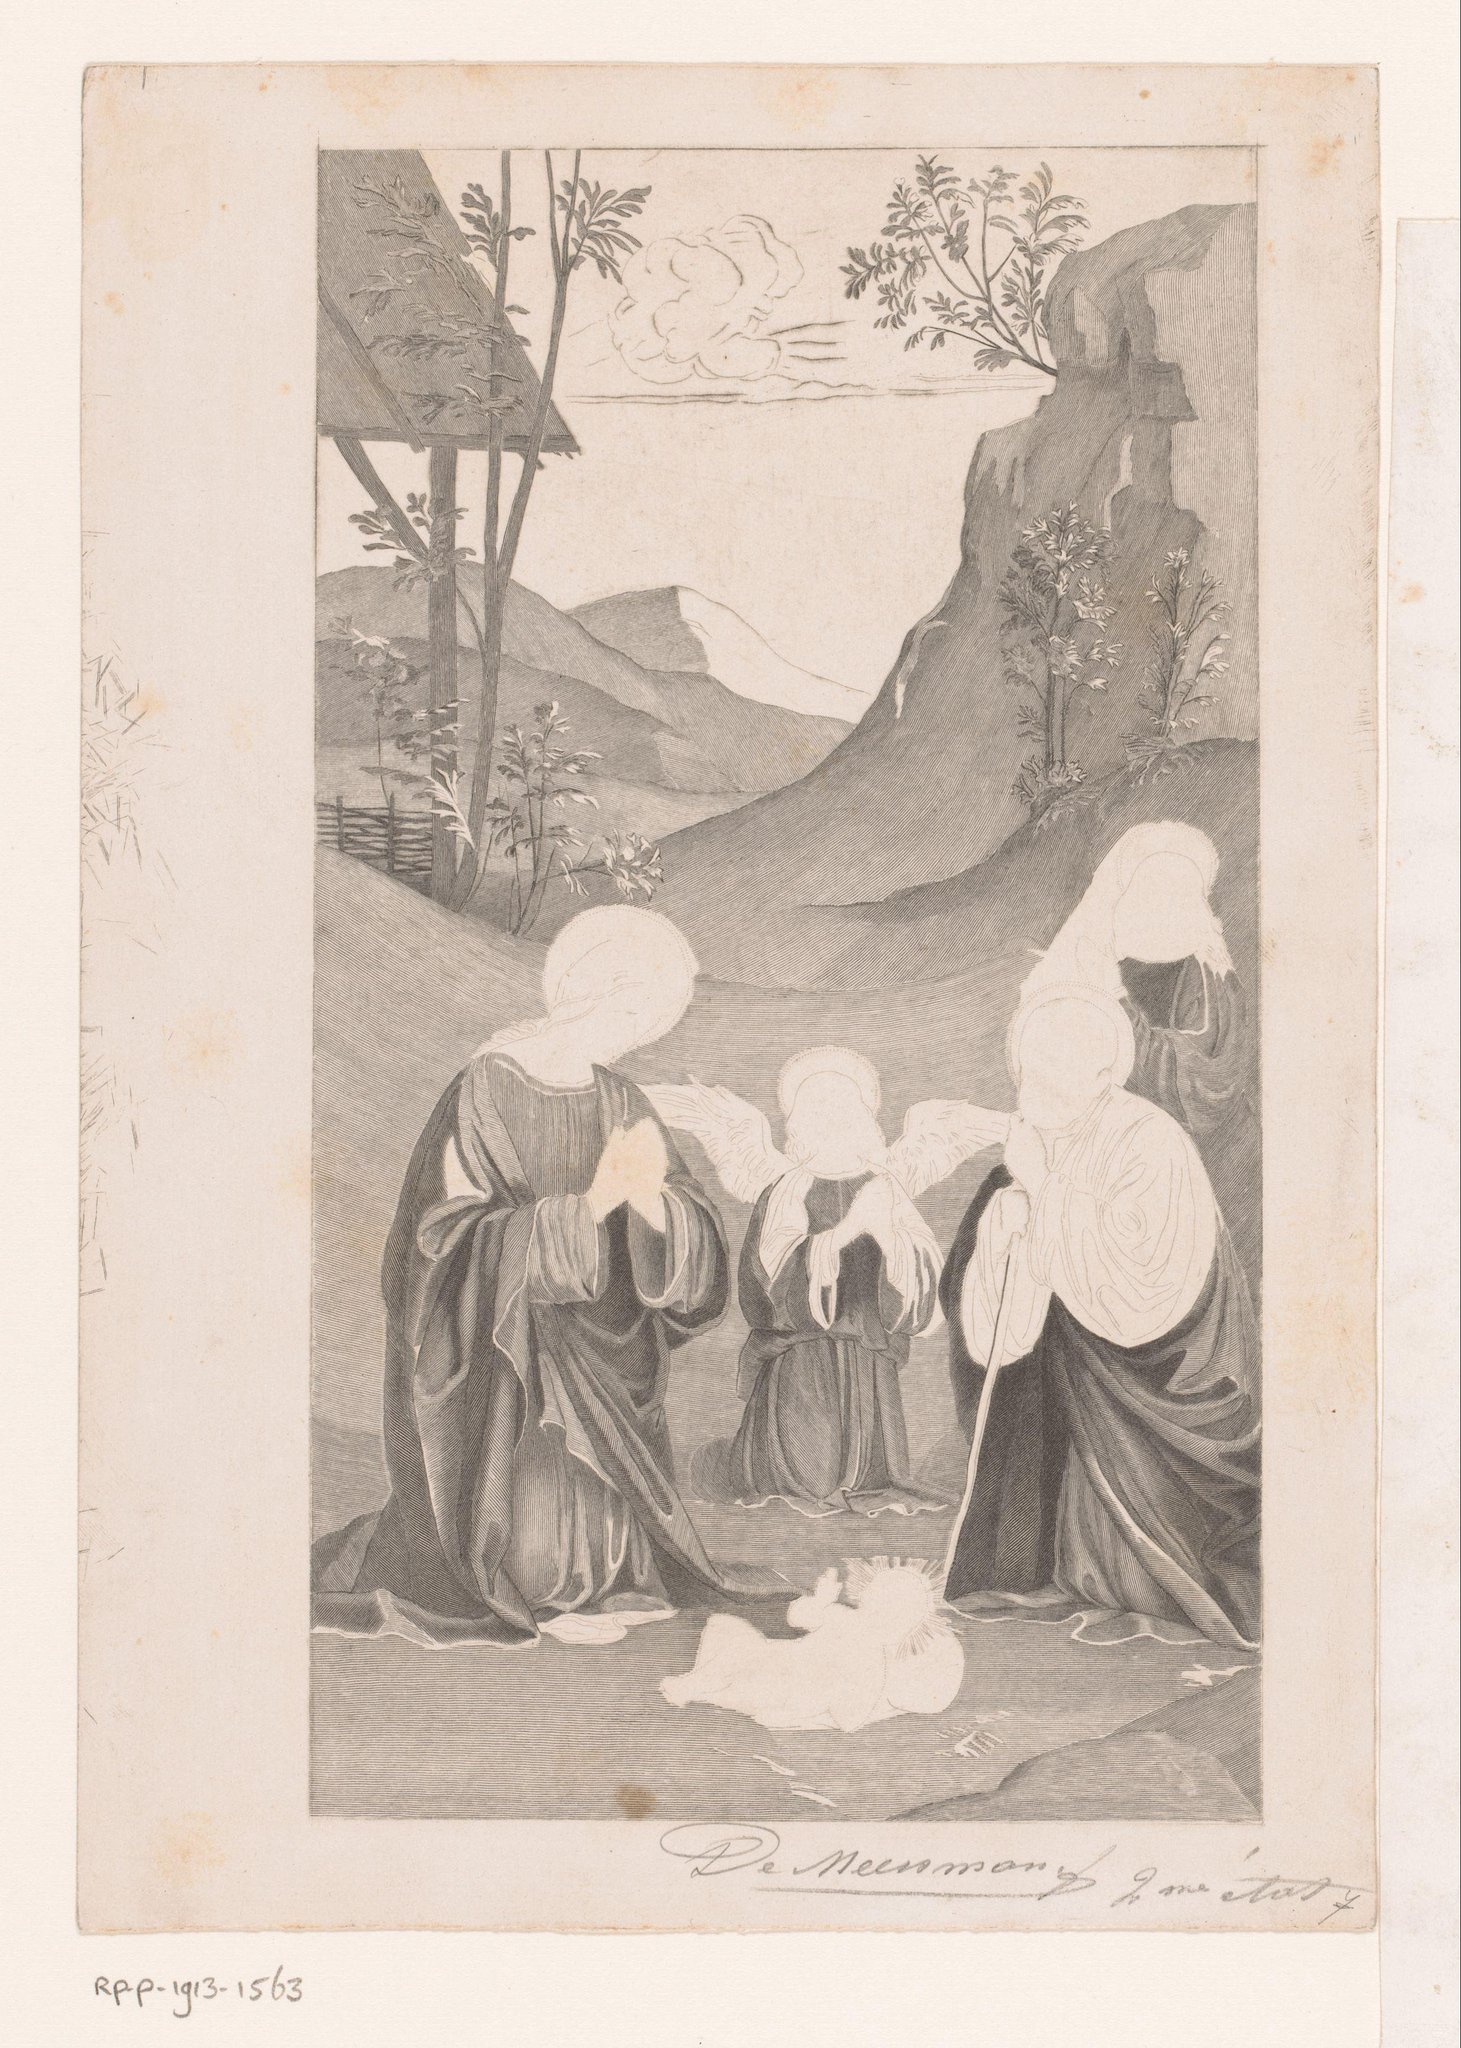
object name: print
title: Geboorte van Christus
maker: françois de meersman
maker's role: print maker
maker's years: 1830-1905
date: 1840-1905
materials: paper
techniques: drypoint, etching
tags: story of the birth of christ (luke 2:1-20), (high) hill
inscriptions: inscription: ‘2me état’, collector's mark: Lugt 2228